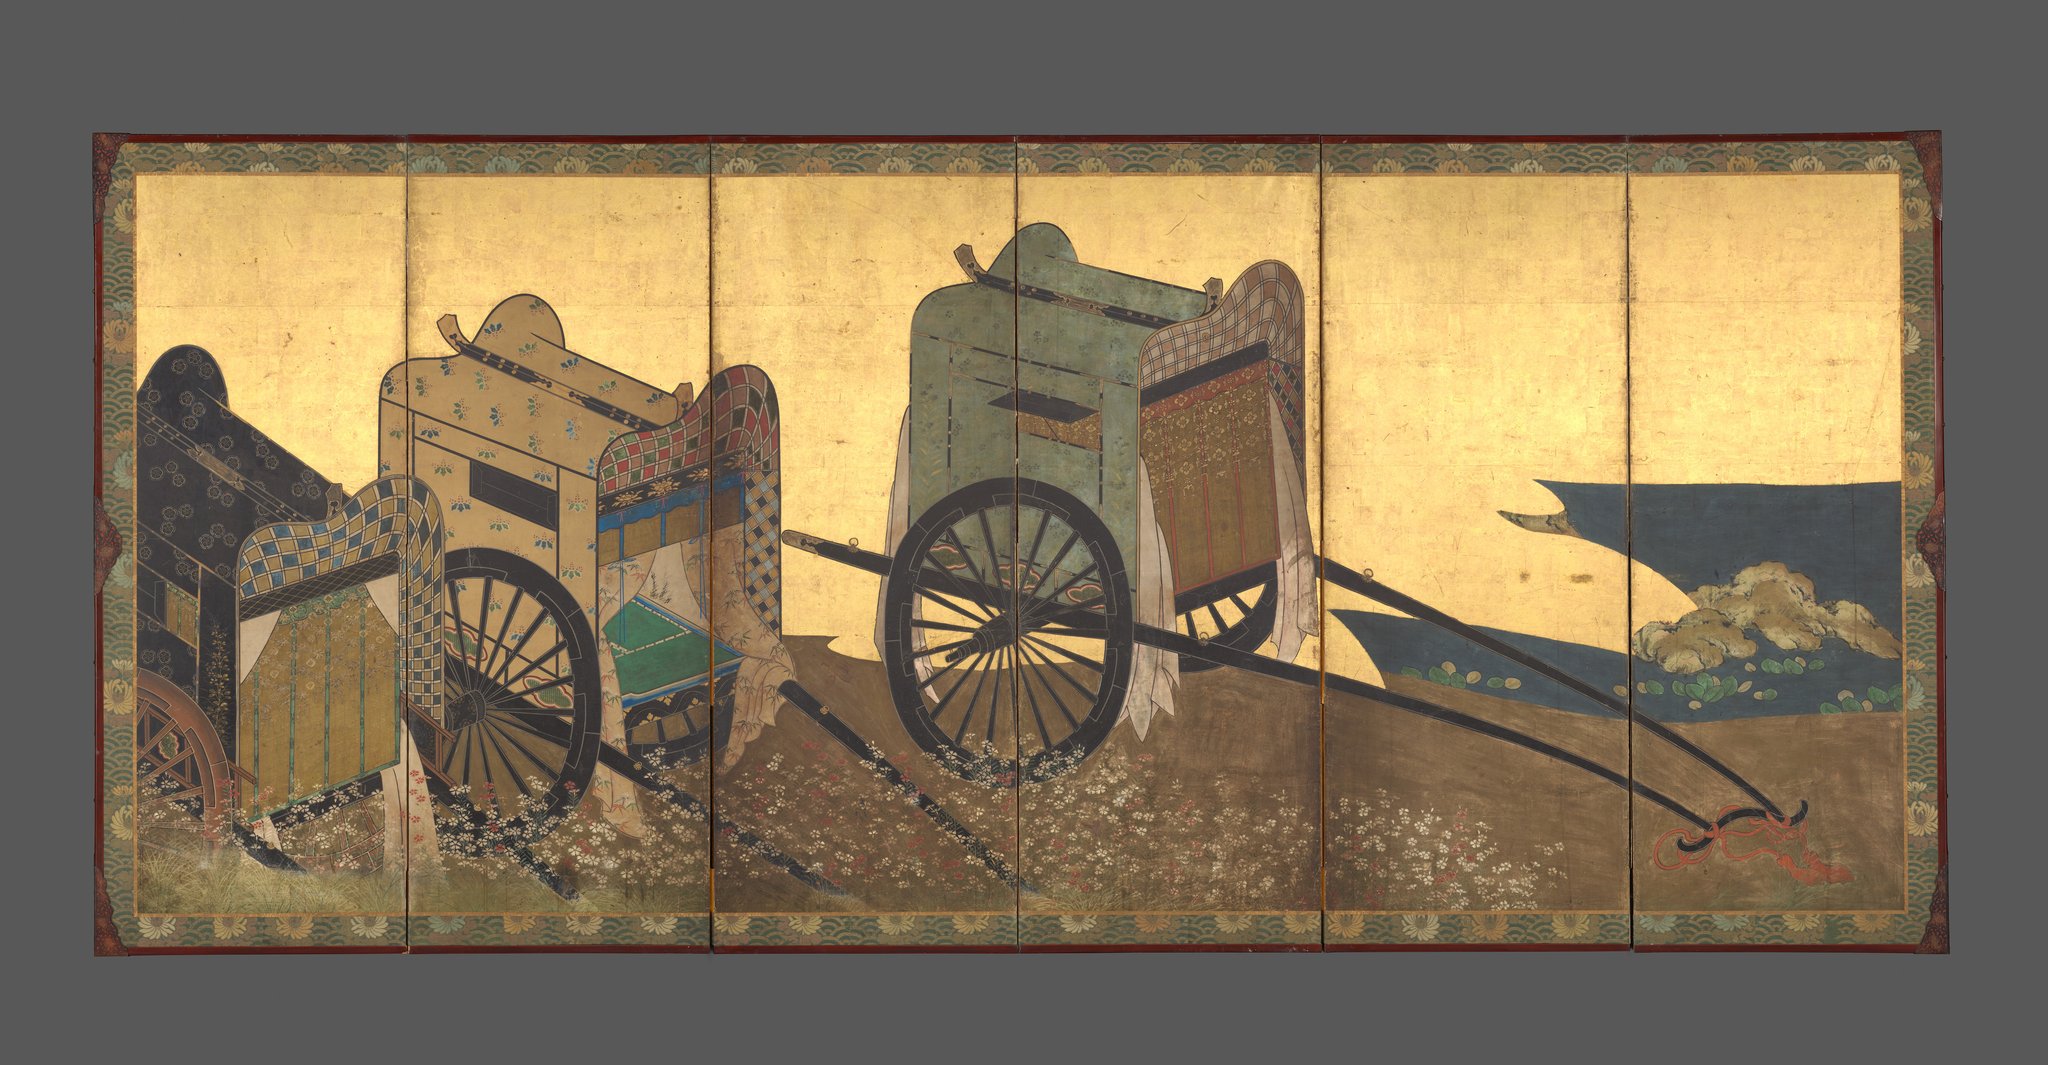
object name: screen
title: Imperial Carts (Gosho guruma)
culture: japanese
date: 1634-1666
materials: gold, gold leaf, ink, panel, paper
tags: carts